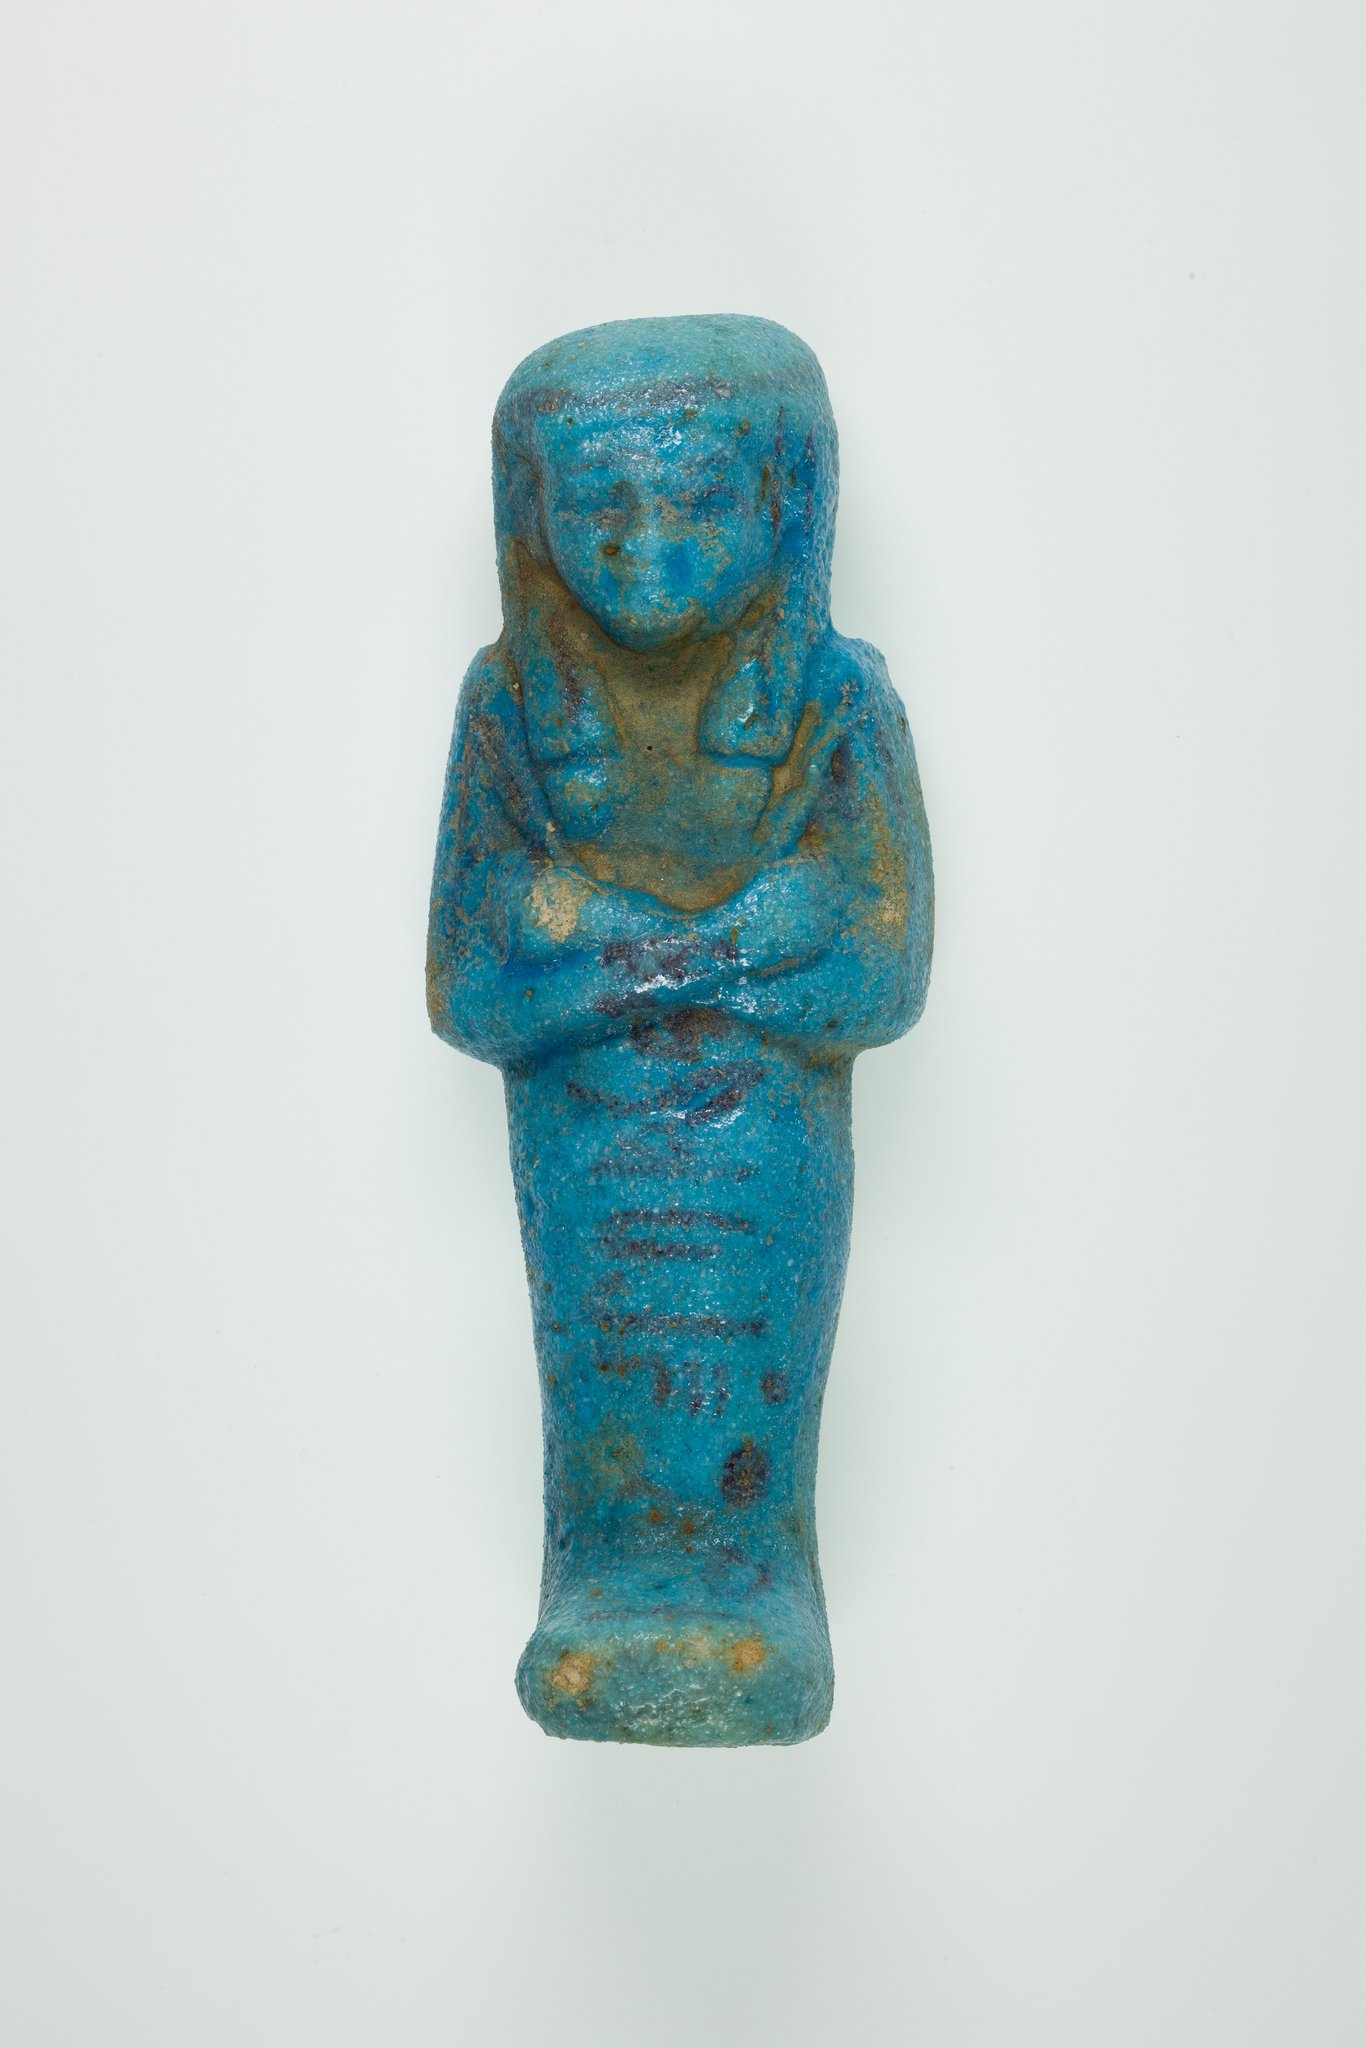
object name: worker shabti, henettawy c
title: Worker Shabti of Henettawy (C), Daughter of Isetemkheb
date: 990-970 BCE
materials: faience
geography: egypt